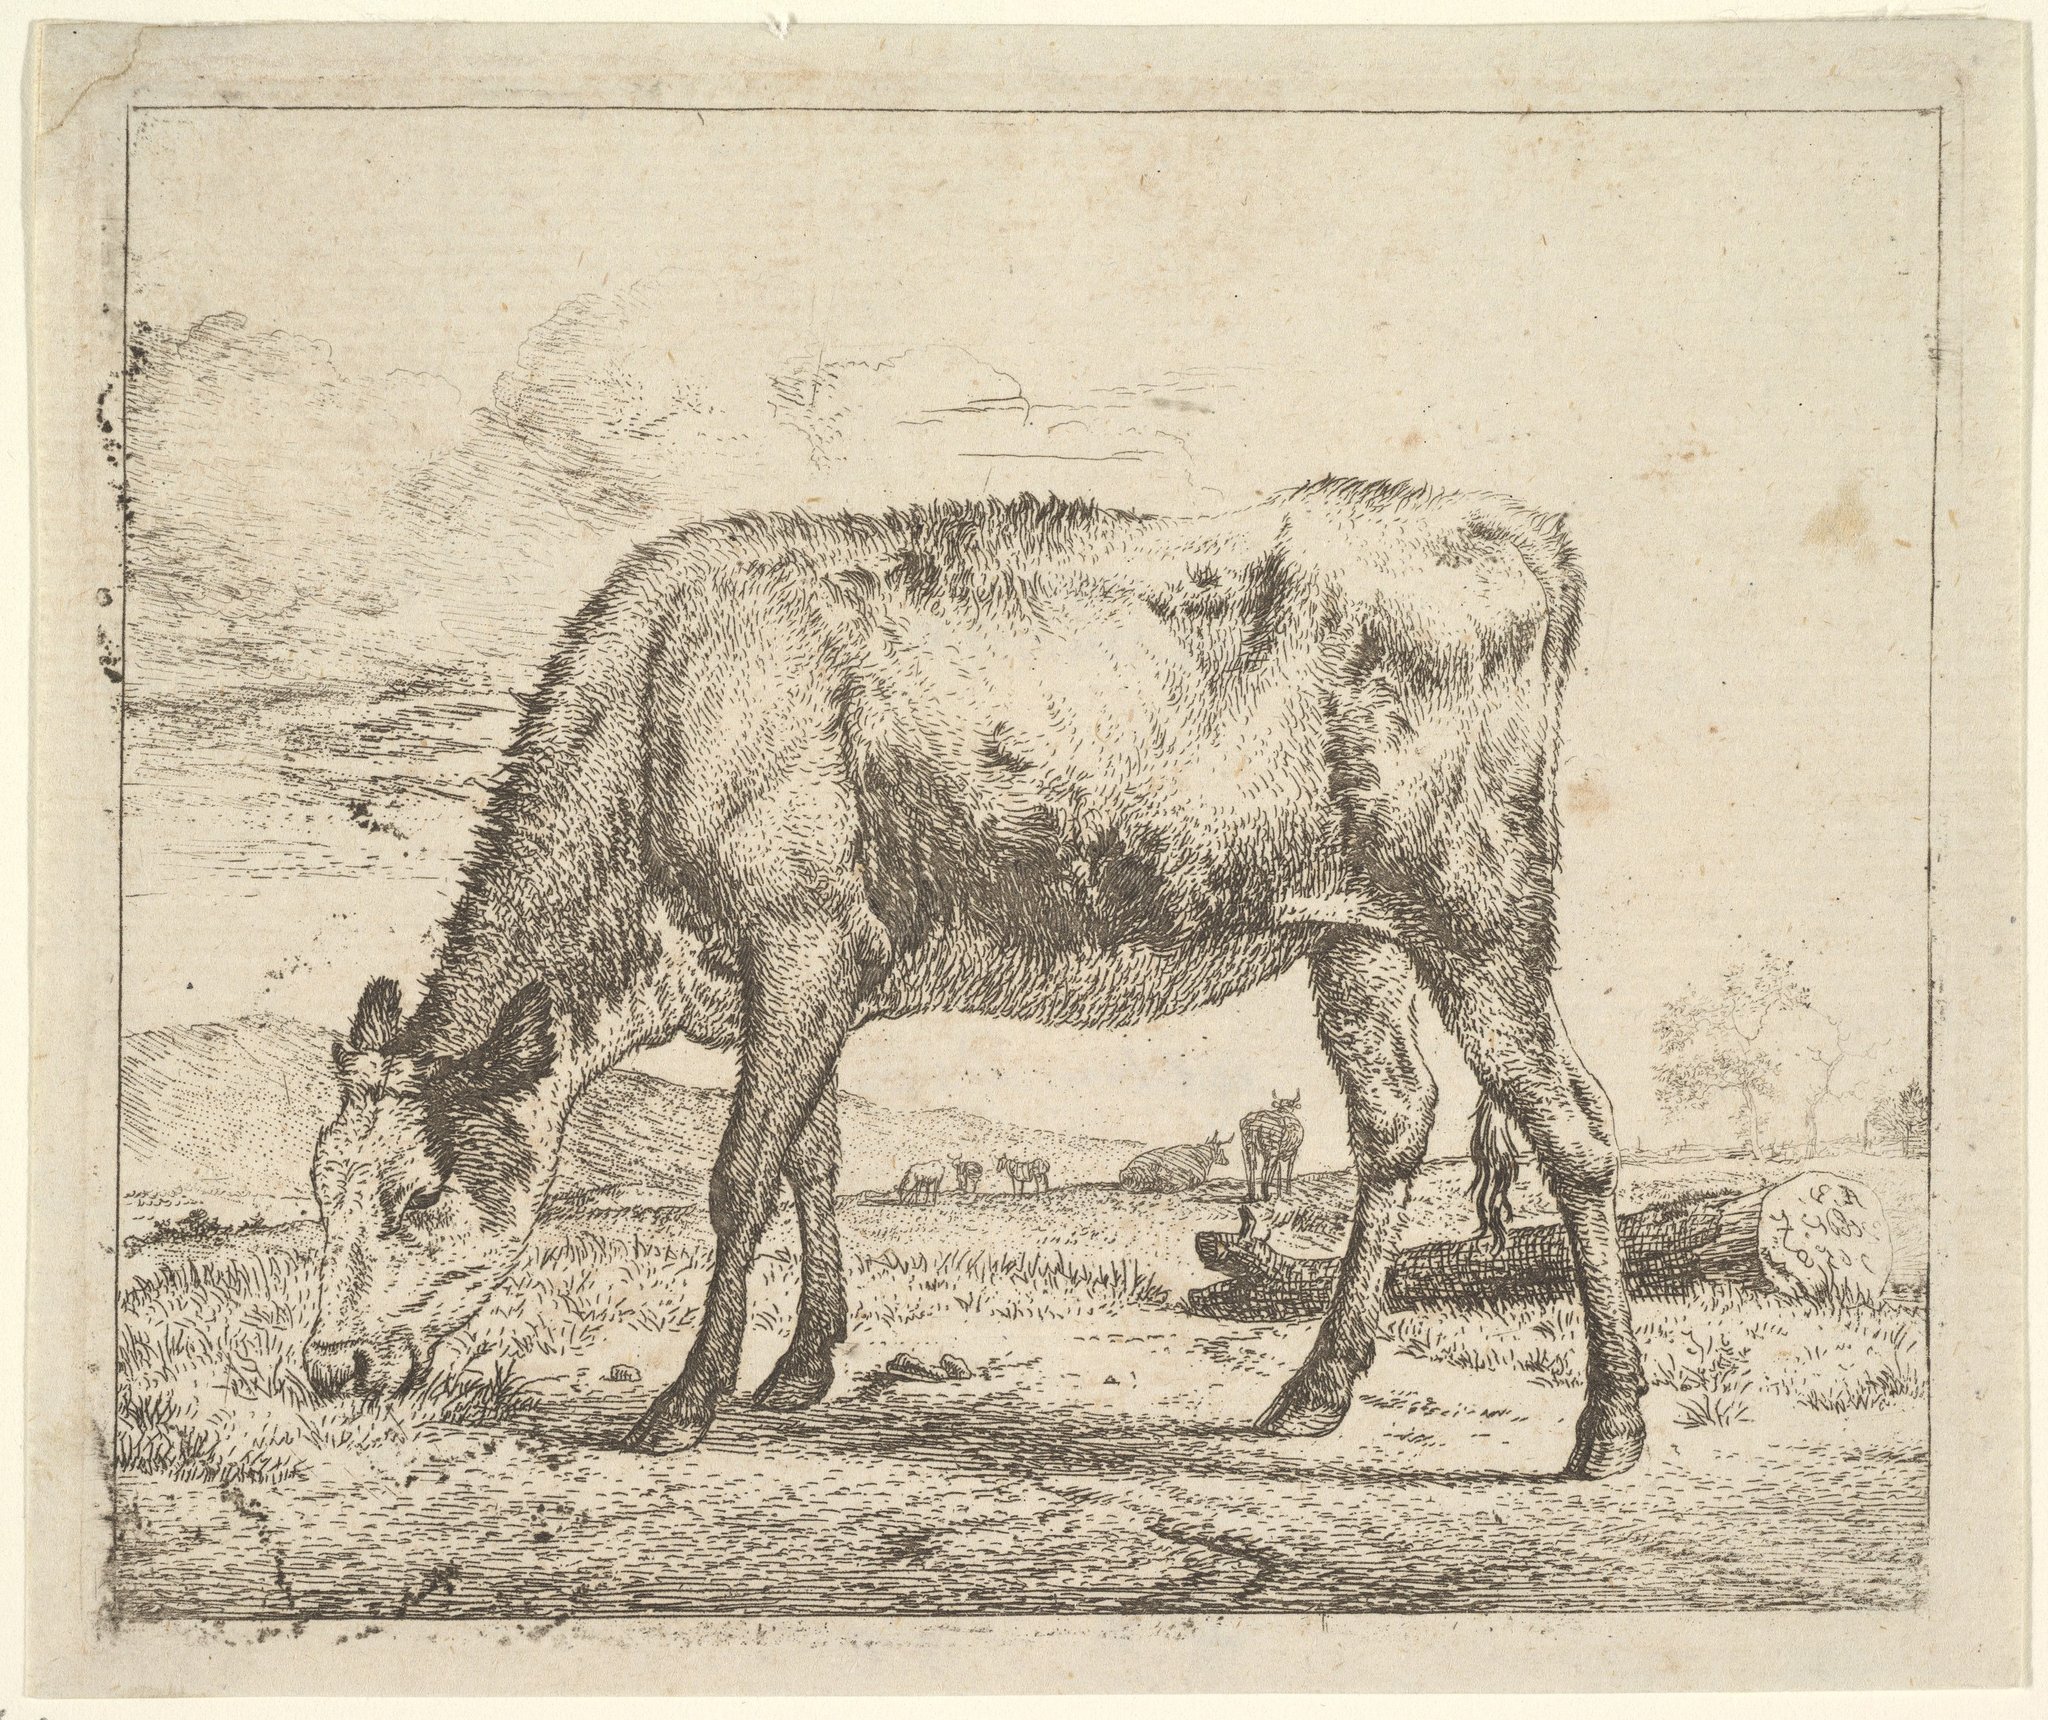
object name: print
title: Grazing Calf, plate 8 from "Different Animals"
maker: adriaen van de velde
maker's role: artist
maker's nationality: dutch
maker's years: 1636-1672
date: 1658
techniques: etching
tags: cows